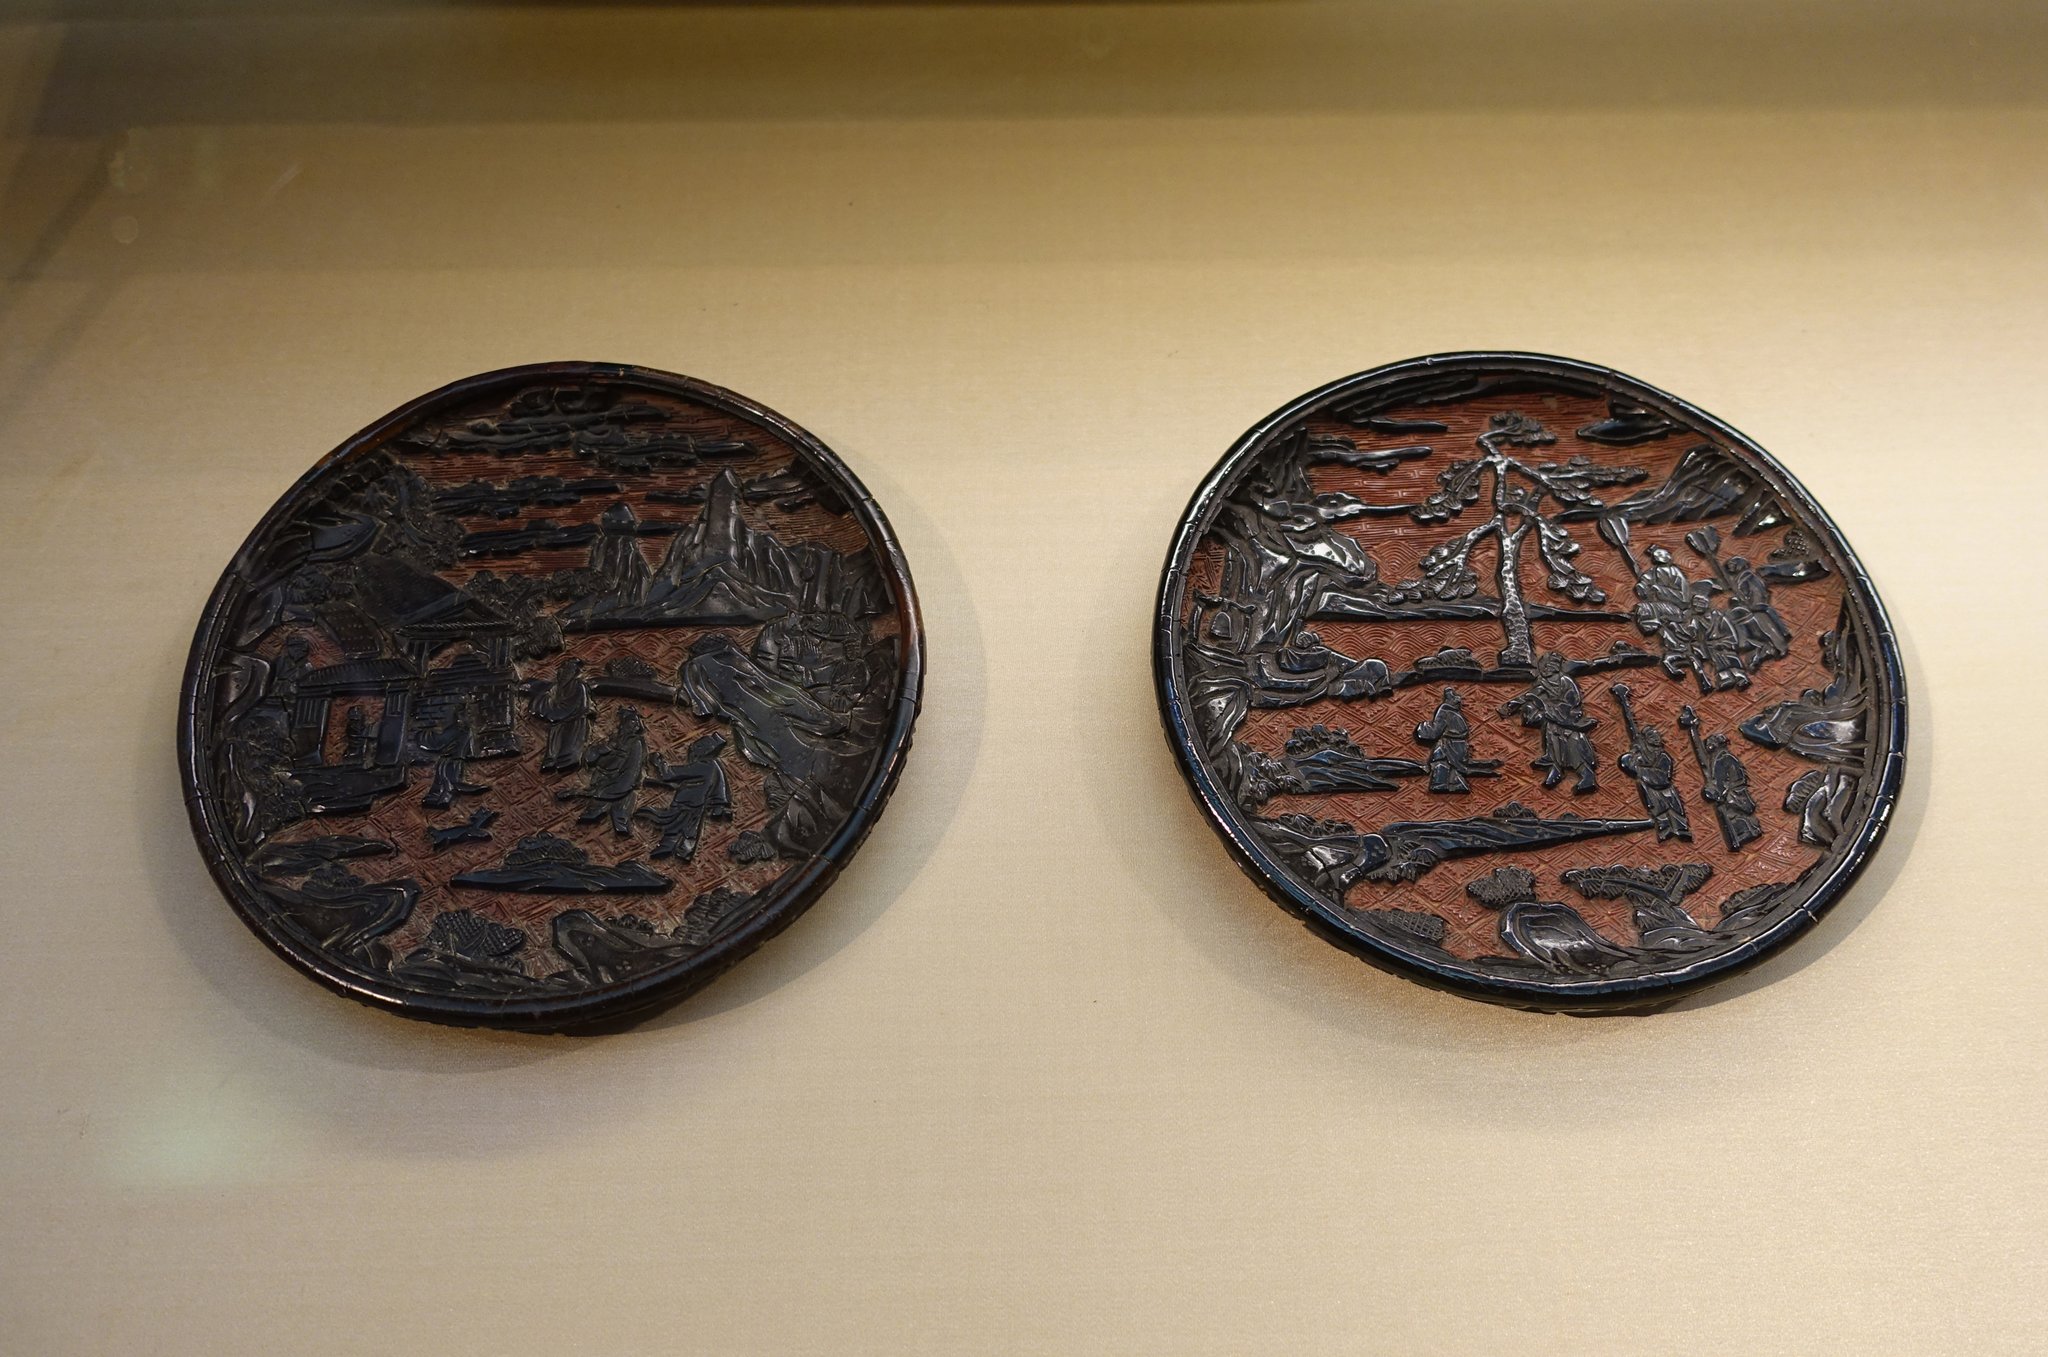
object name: dish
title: Pair of dishes with scenes from Romance of the Three Kingdoms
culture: chinese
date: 1367-1400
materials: lacquer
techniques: carving